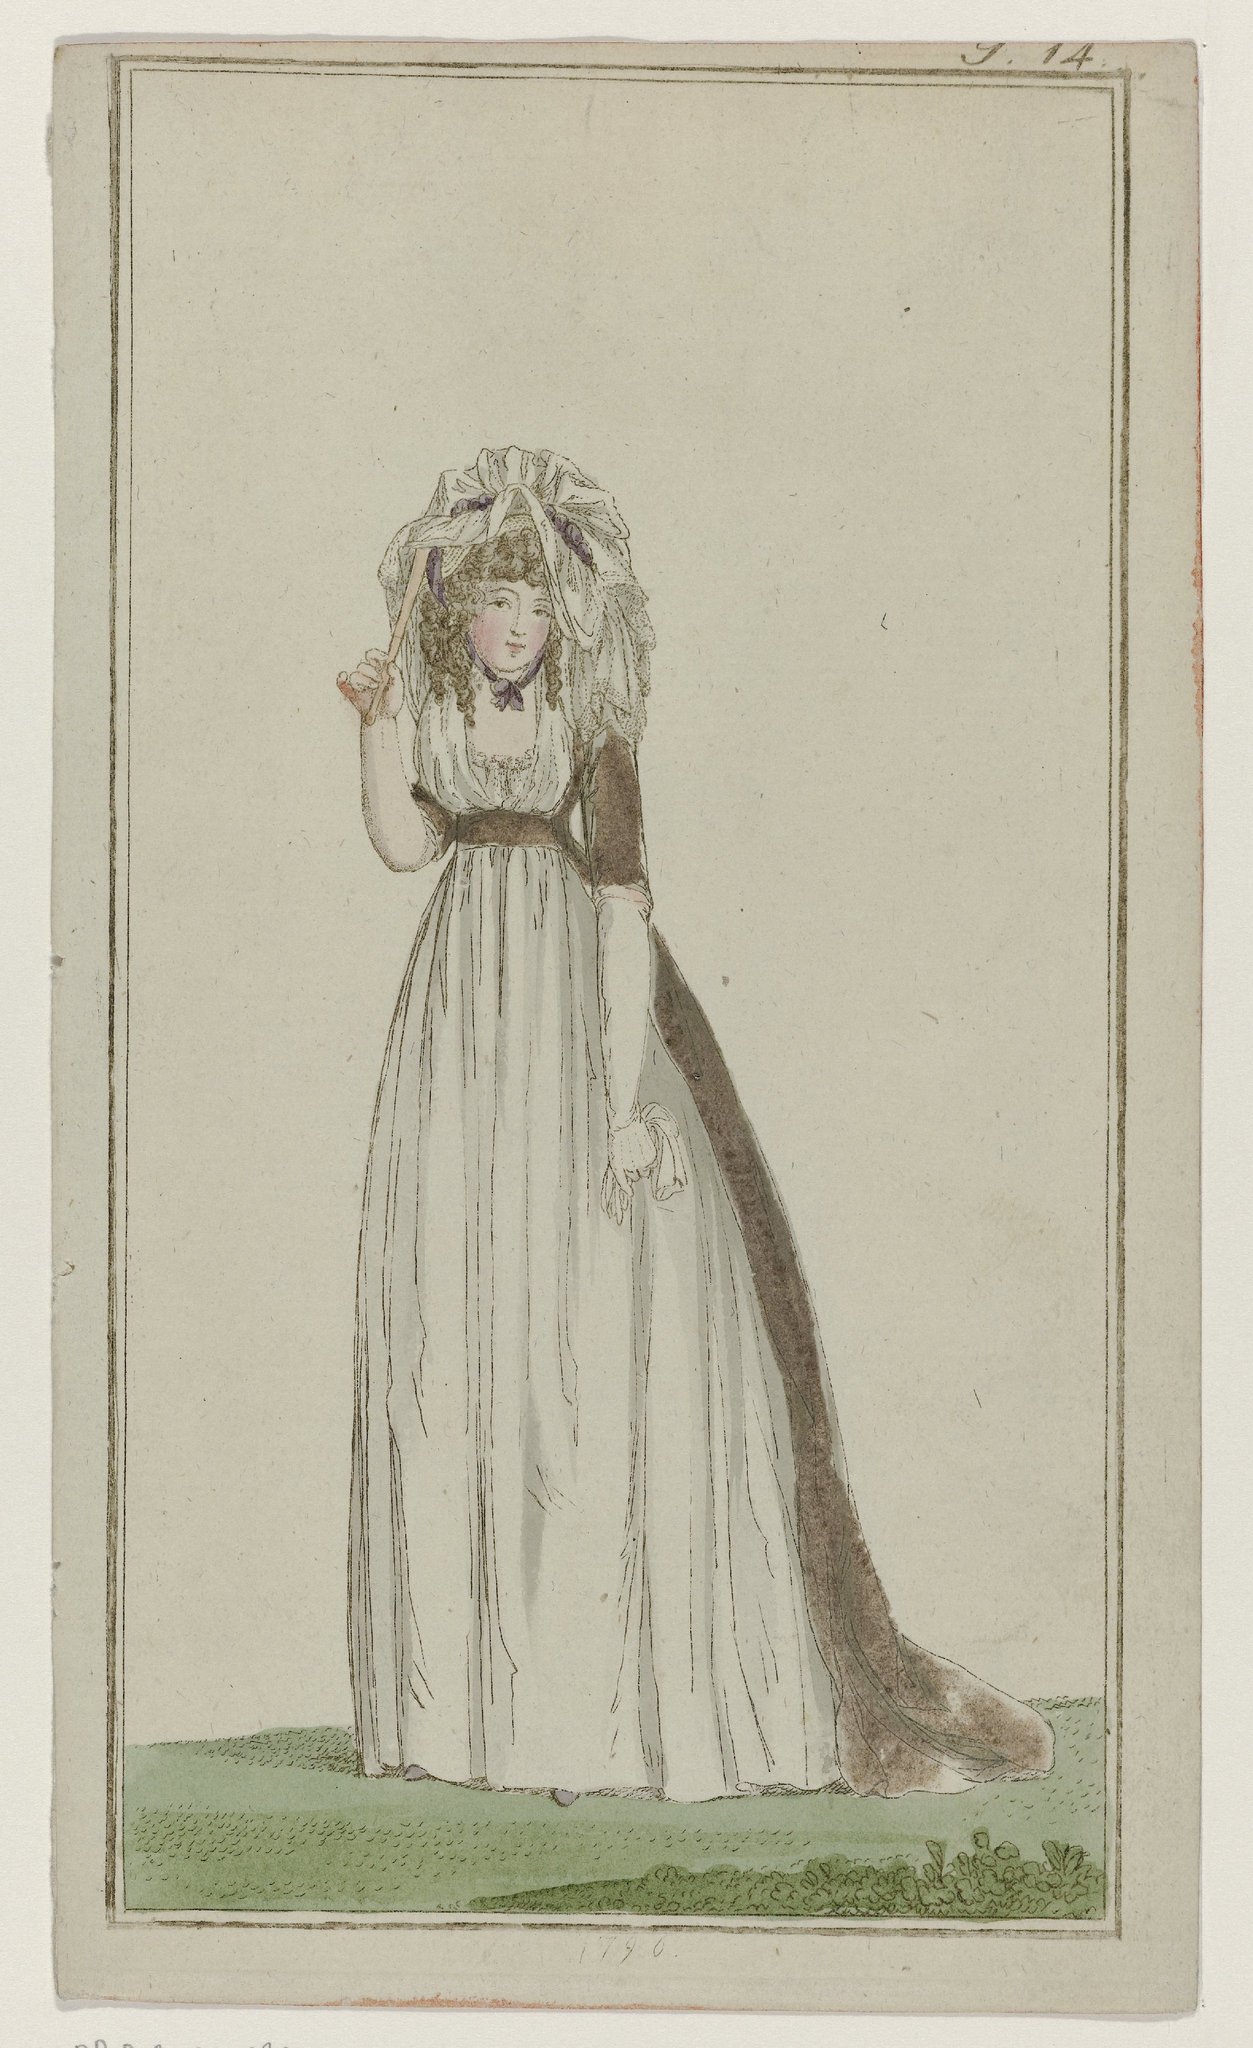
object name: fashion print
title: Journal des Luxus und der Moden, 1796, T 14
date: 1796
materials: paper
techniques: etching, hand coloring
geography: weimar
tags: head-gear: cap (+ women's clothes), fashion plates, gloves, mittens, etc. (+ women's clothes), dress, gown (+ women's clothes), fan (+ women's clothes), piece of clothing covering the breast or décolleté (fichu) (+ women's clothes)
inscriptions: date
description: Staande vrouw gekleed in een japon met hoge taille en sleep. Op het hoofd een muts versierd met lint. Met haar waaier tilt ze de muts op. In de linkerhand een losse lange handschoen. Prent uit het modetijdschrift Journal des Luxus und der Moden, uitgegeven door Friedrich Justin Bertuch en Georg Melchior Kraus, Weimar, 1786-1826.